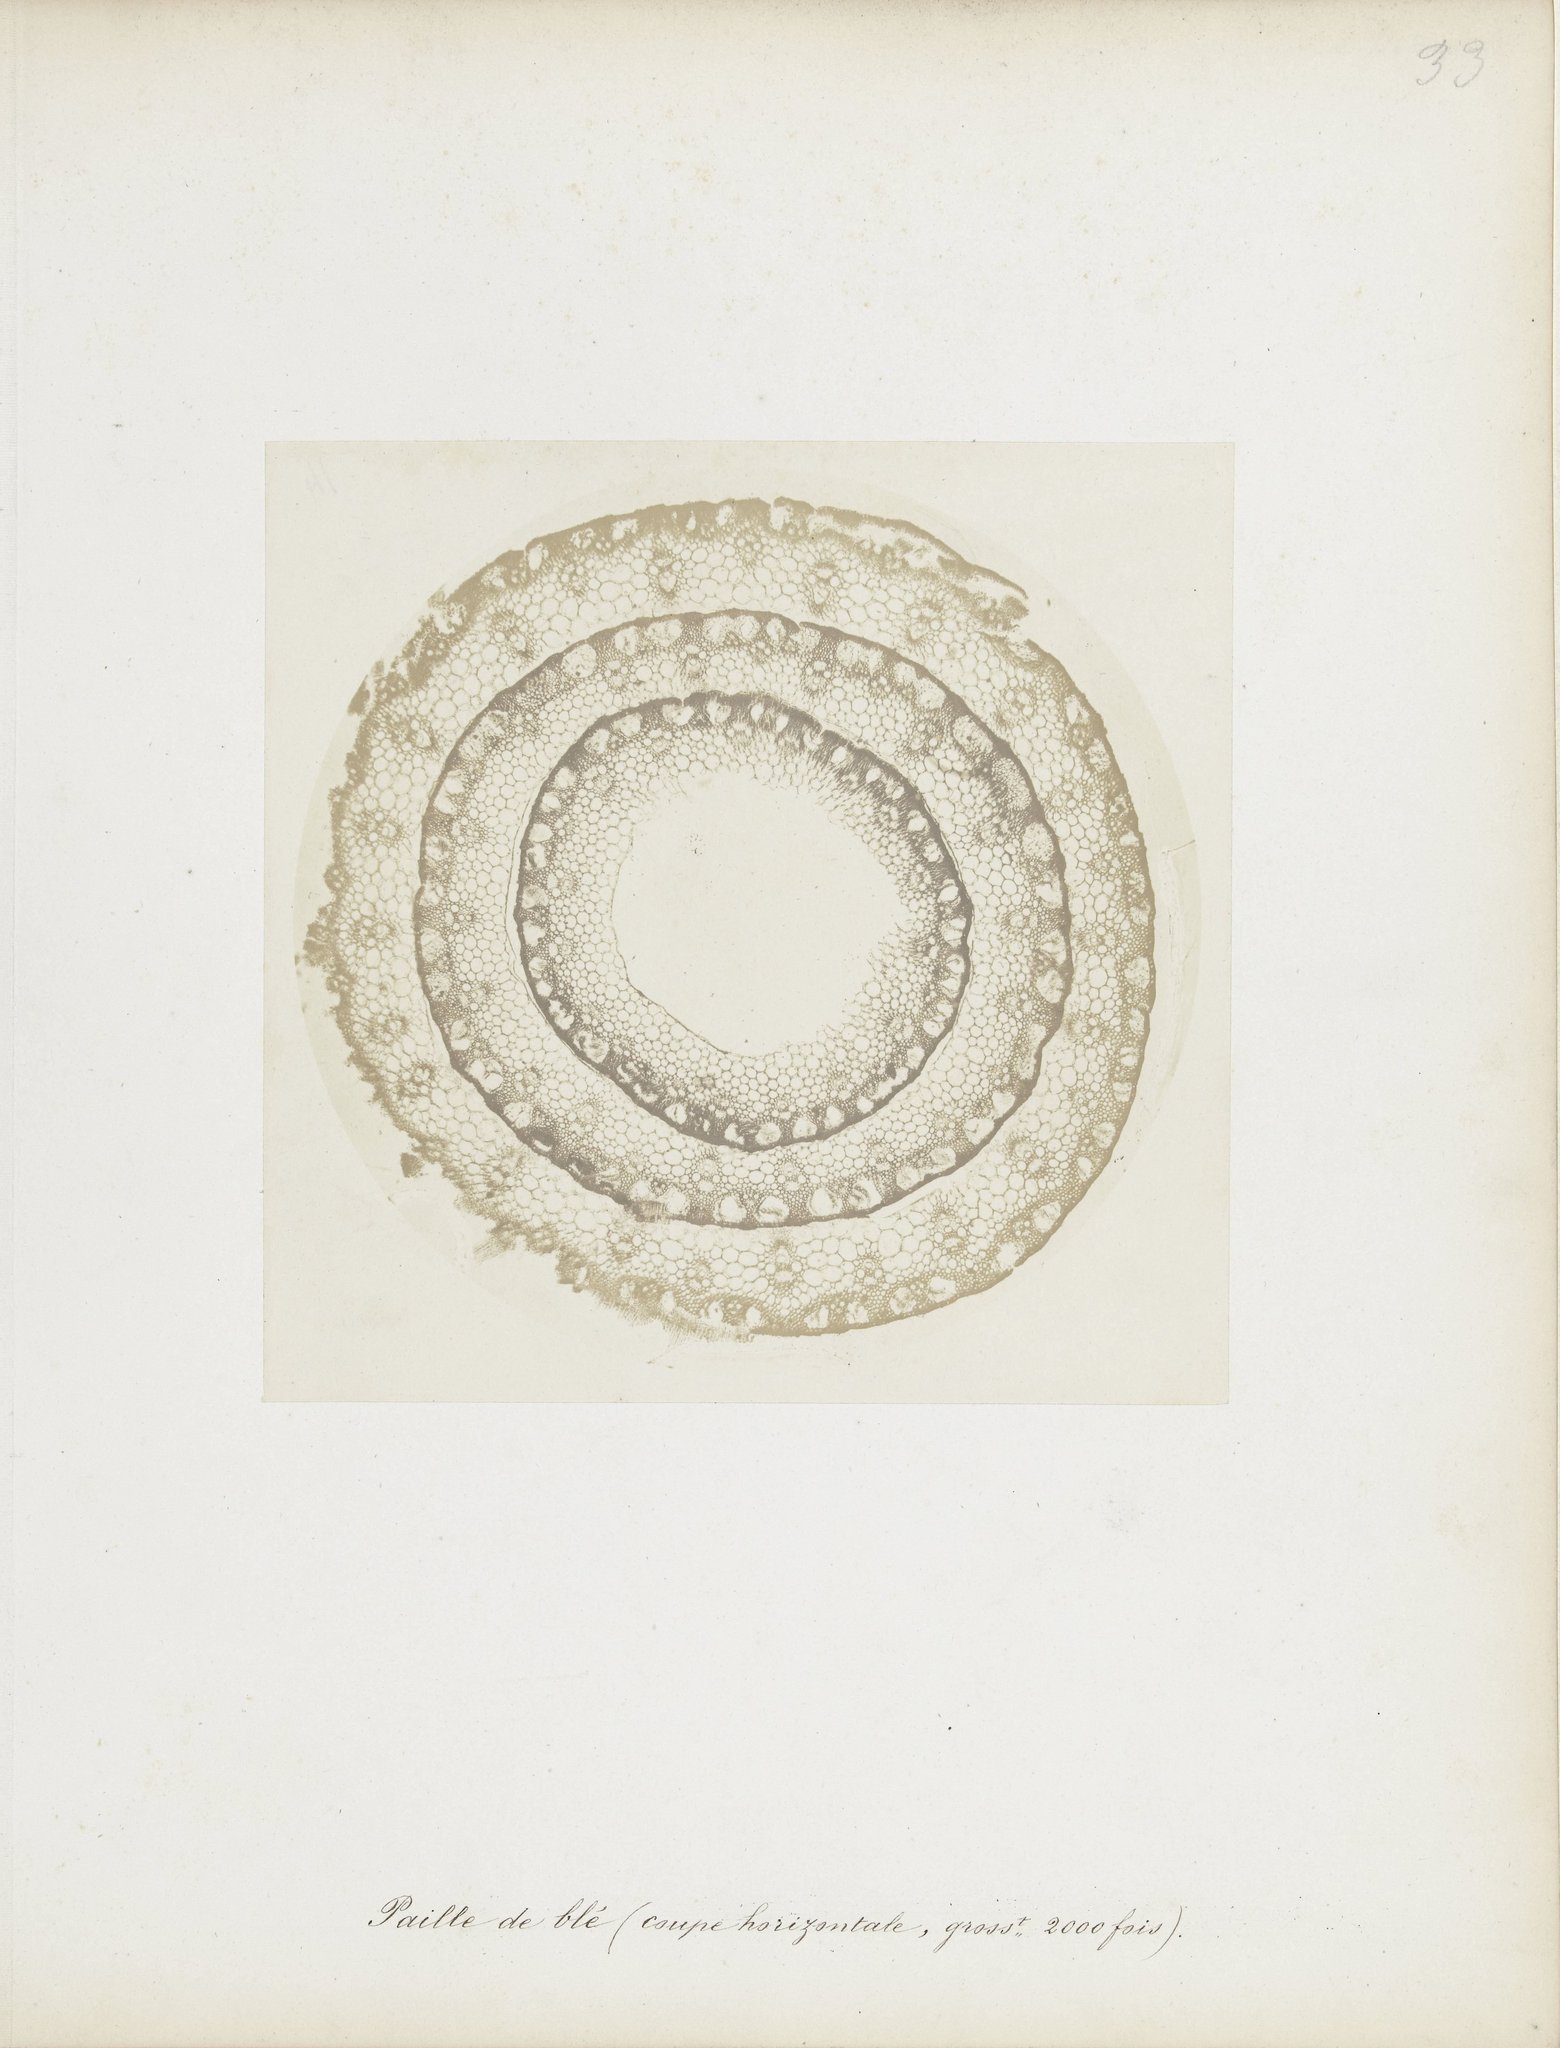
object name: micro opname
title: Paille de blé (coupe horizontale, gross +- 2000 fois)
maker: auguste adolphe bertsch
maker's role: fotograaf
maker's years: 1813-1871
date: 1851-1853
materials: cardboard, paper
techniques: salted paper print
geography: france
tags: agricultural products and by-products: straw, france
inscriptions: number: ‘33’